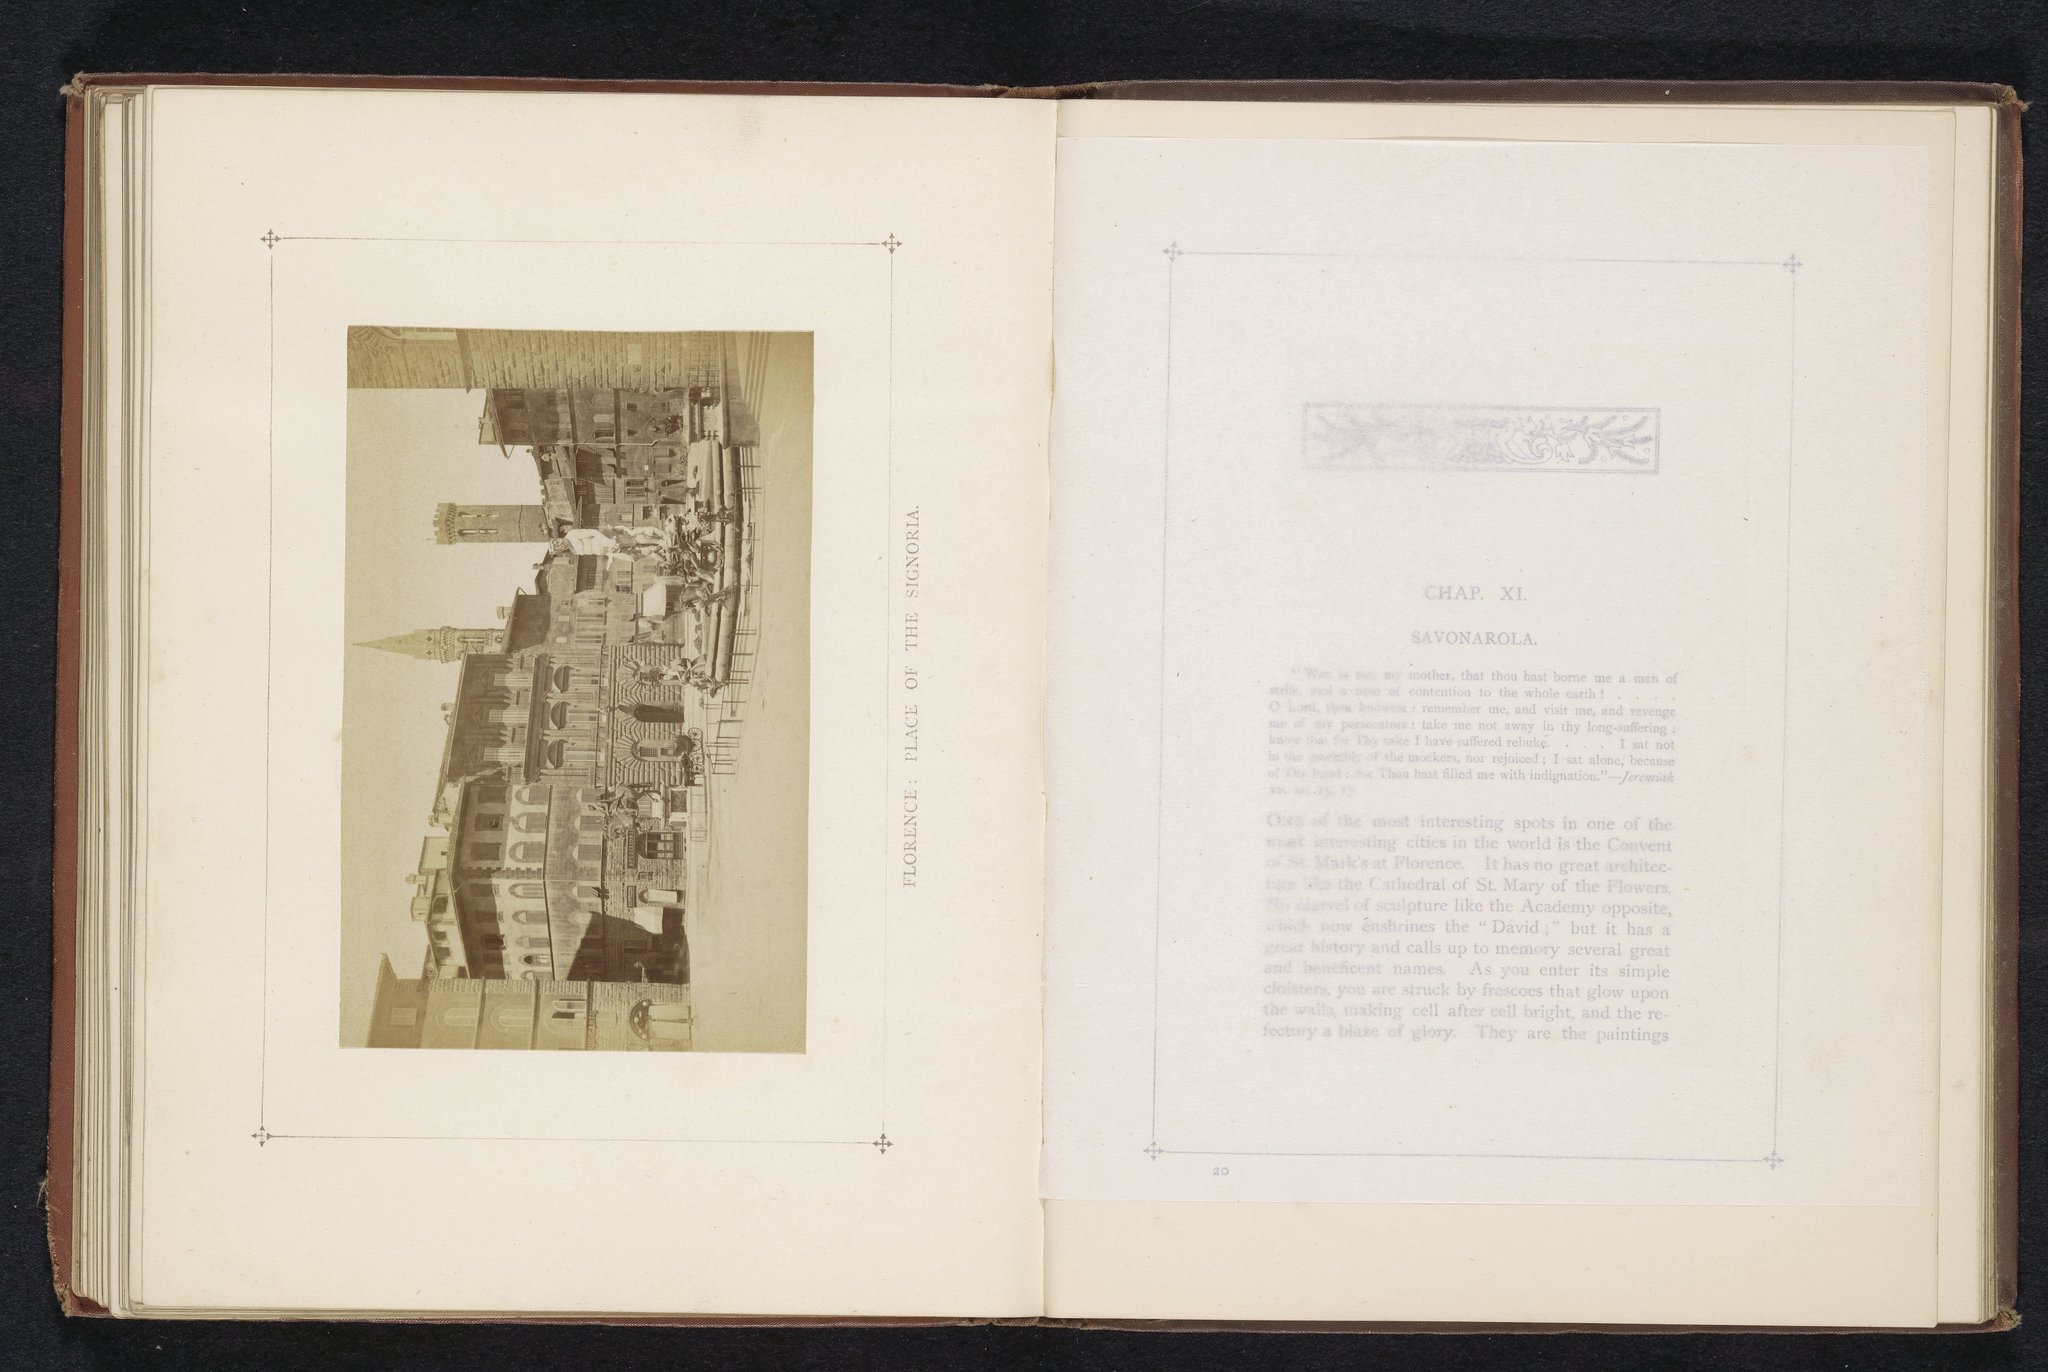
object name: photograph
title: Florence: place of the signoria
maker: Anonymous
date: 1872-1882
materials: photographic support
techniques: albumen print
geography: piazza della signoria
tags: square, place, circus, etc., façade (of house or building)